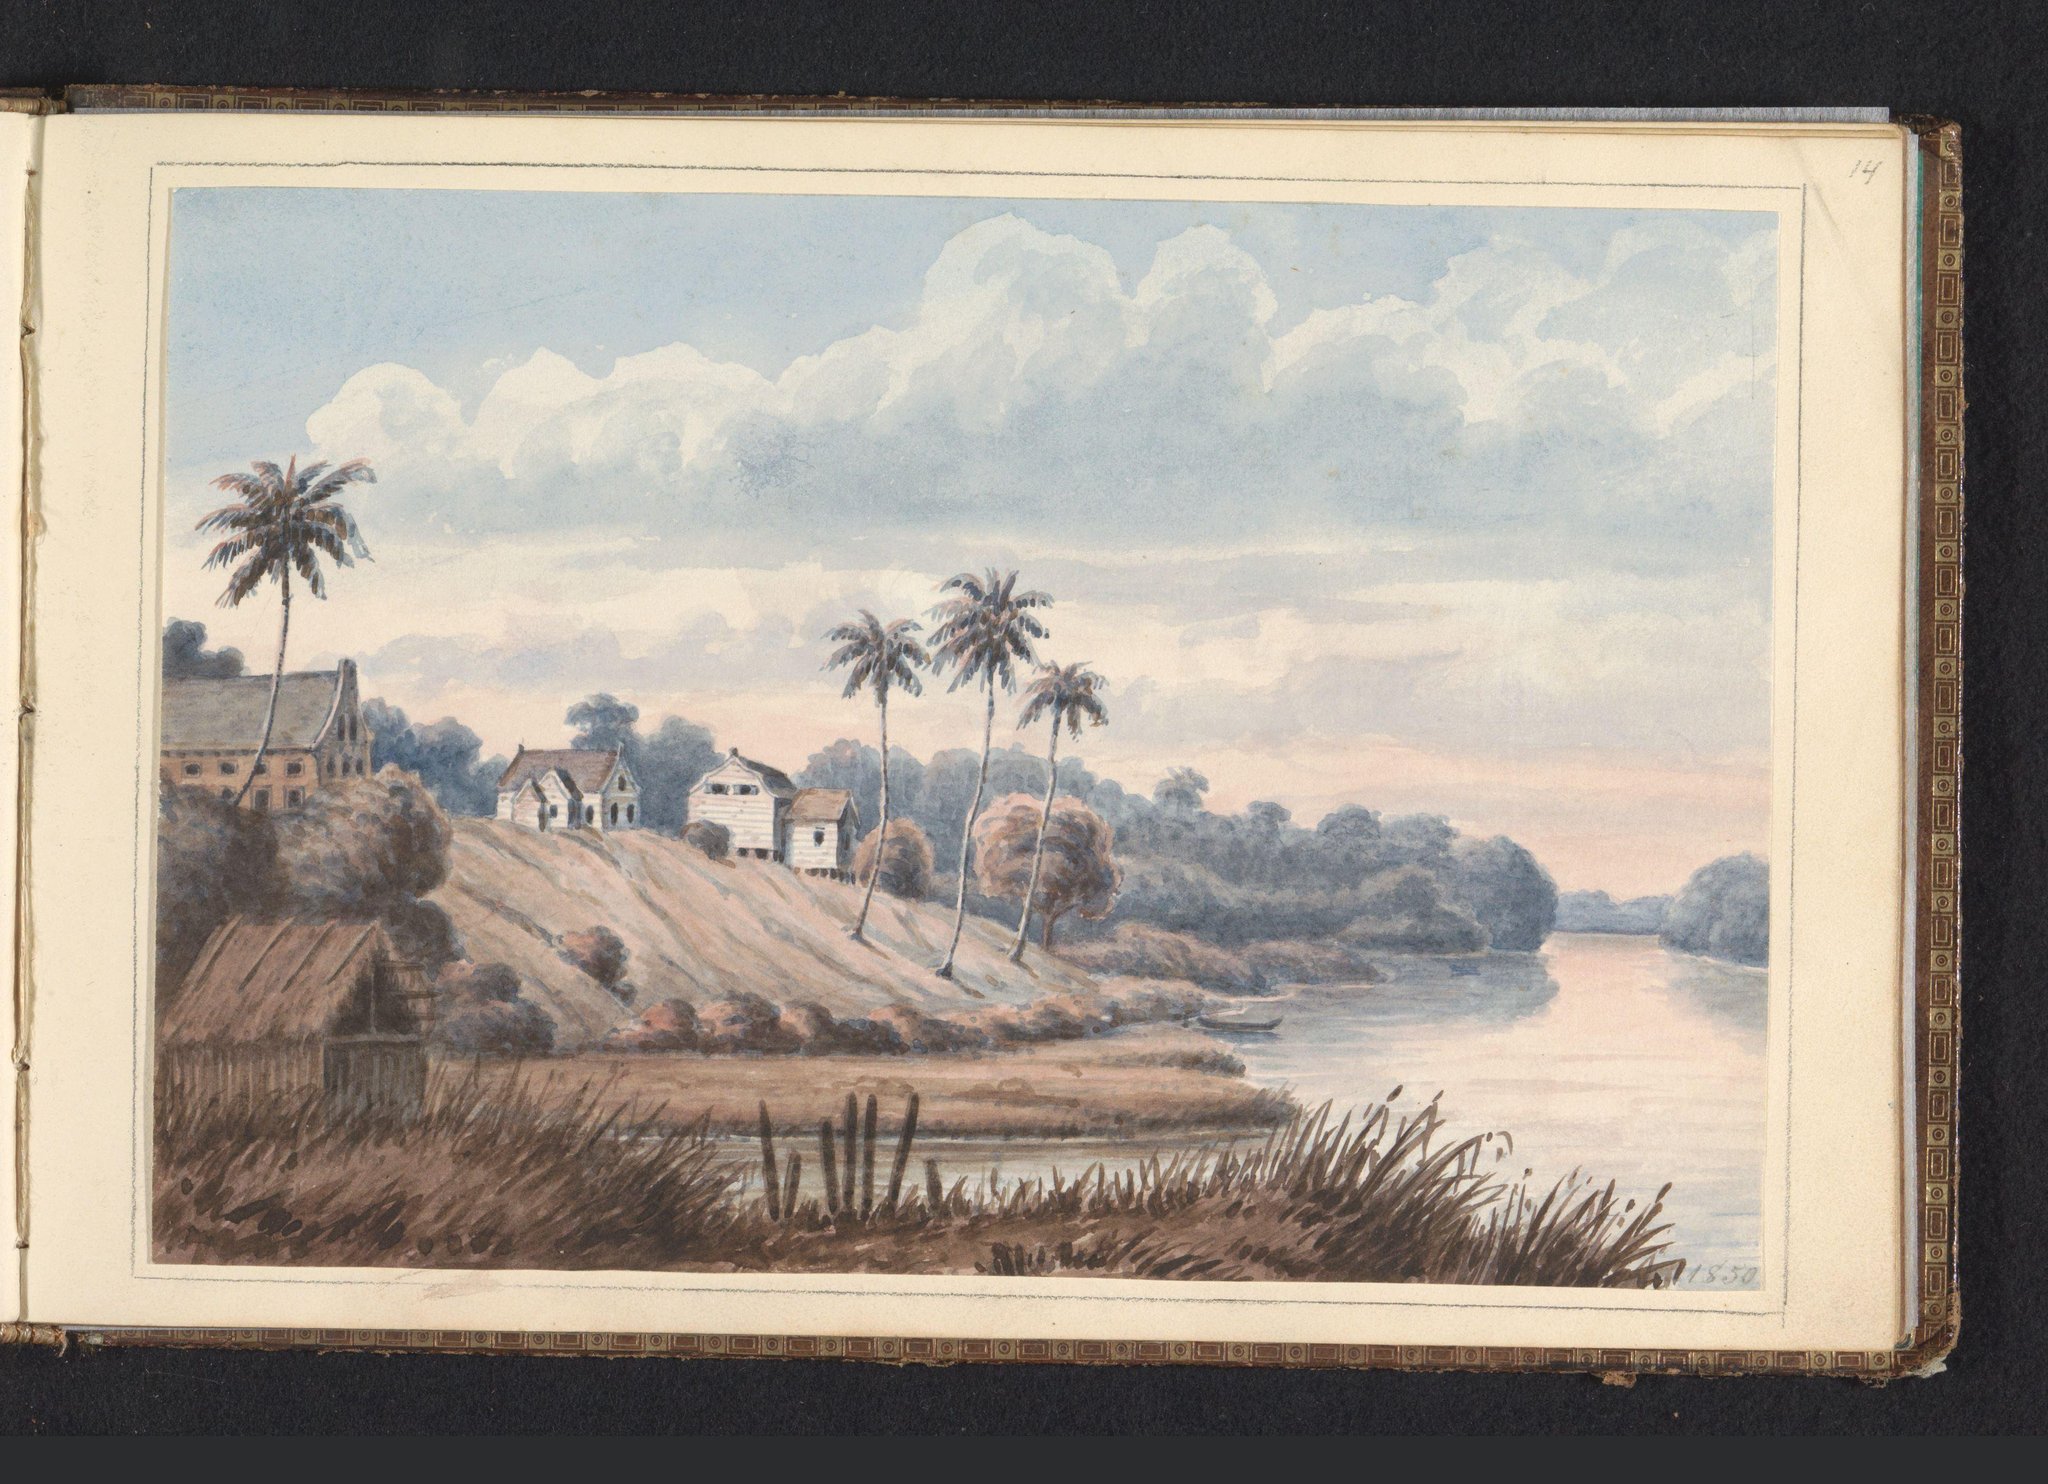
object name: topographical view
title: Joden-Savane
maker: jacob marius adriaan martini van geffen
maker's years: 1821-1866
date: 1850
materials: ink, paper, pencil, watercolor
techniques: brush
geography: suriname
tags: jodensavanne, boven-suriname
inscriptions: inscription: ‘.’, signature and date: ‘gedateerd recto r.o.: 1850’